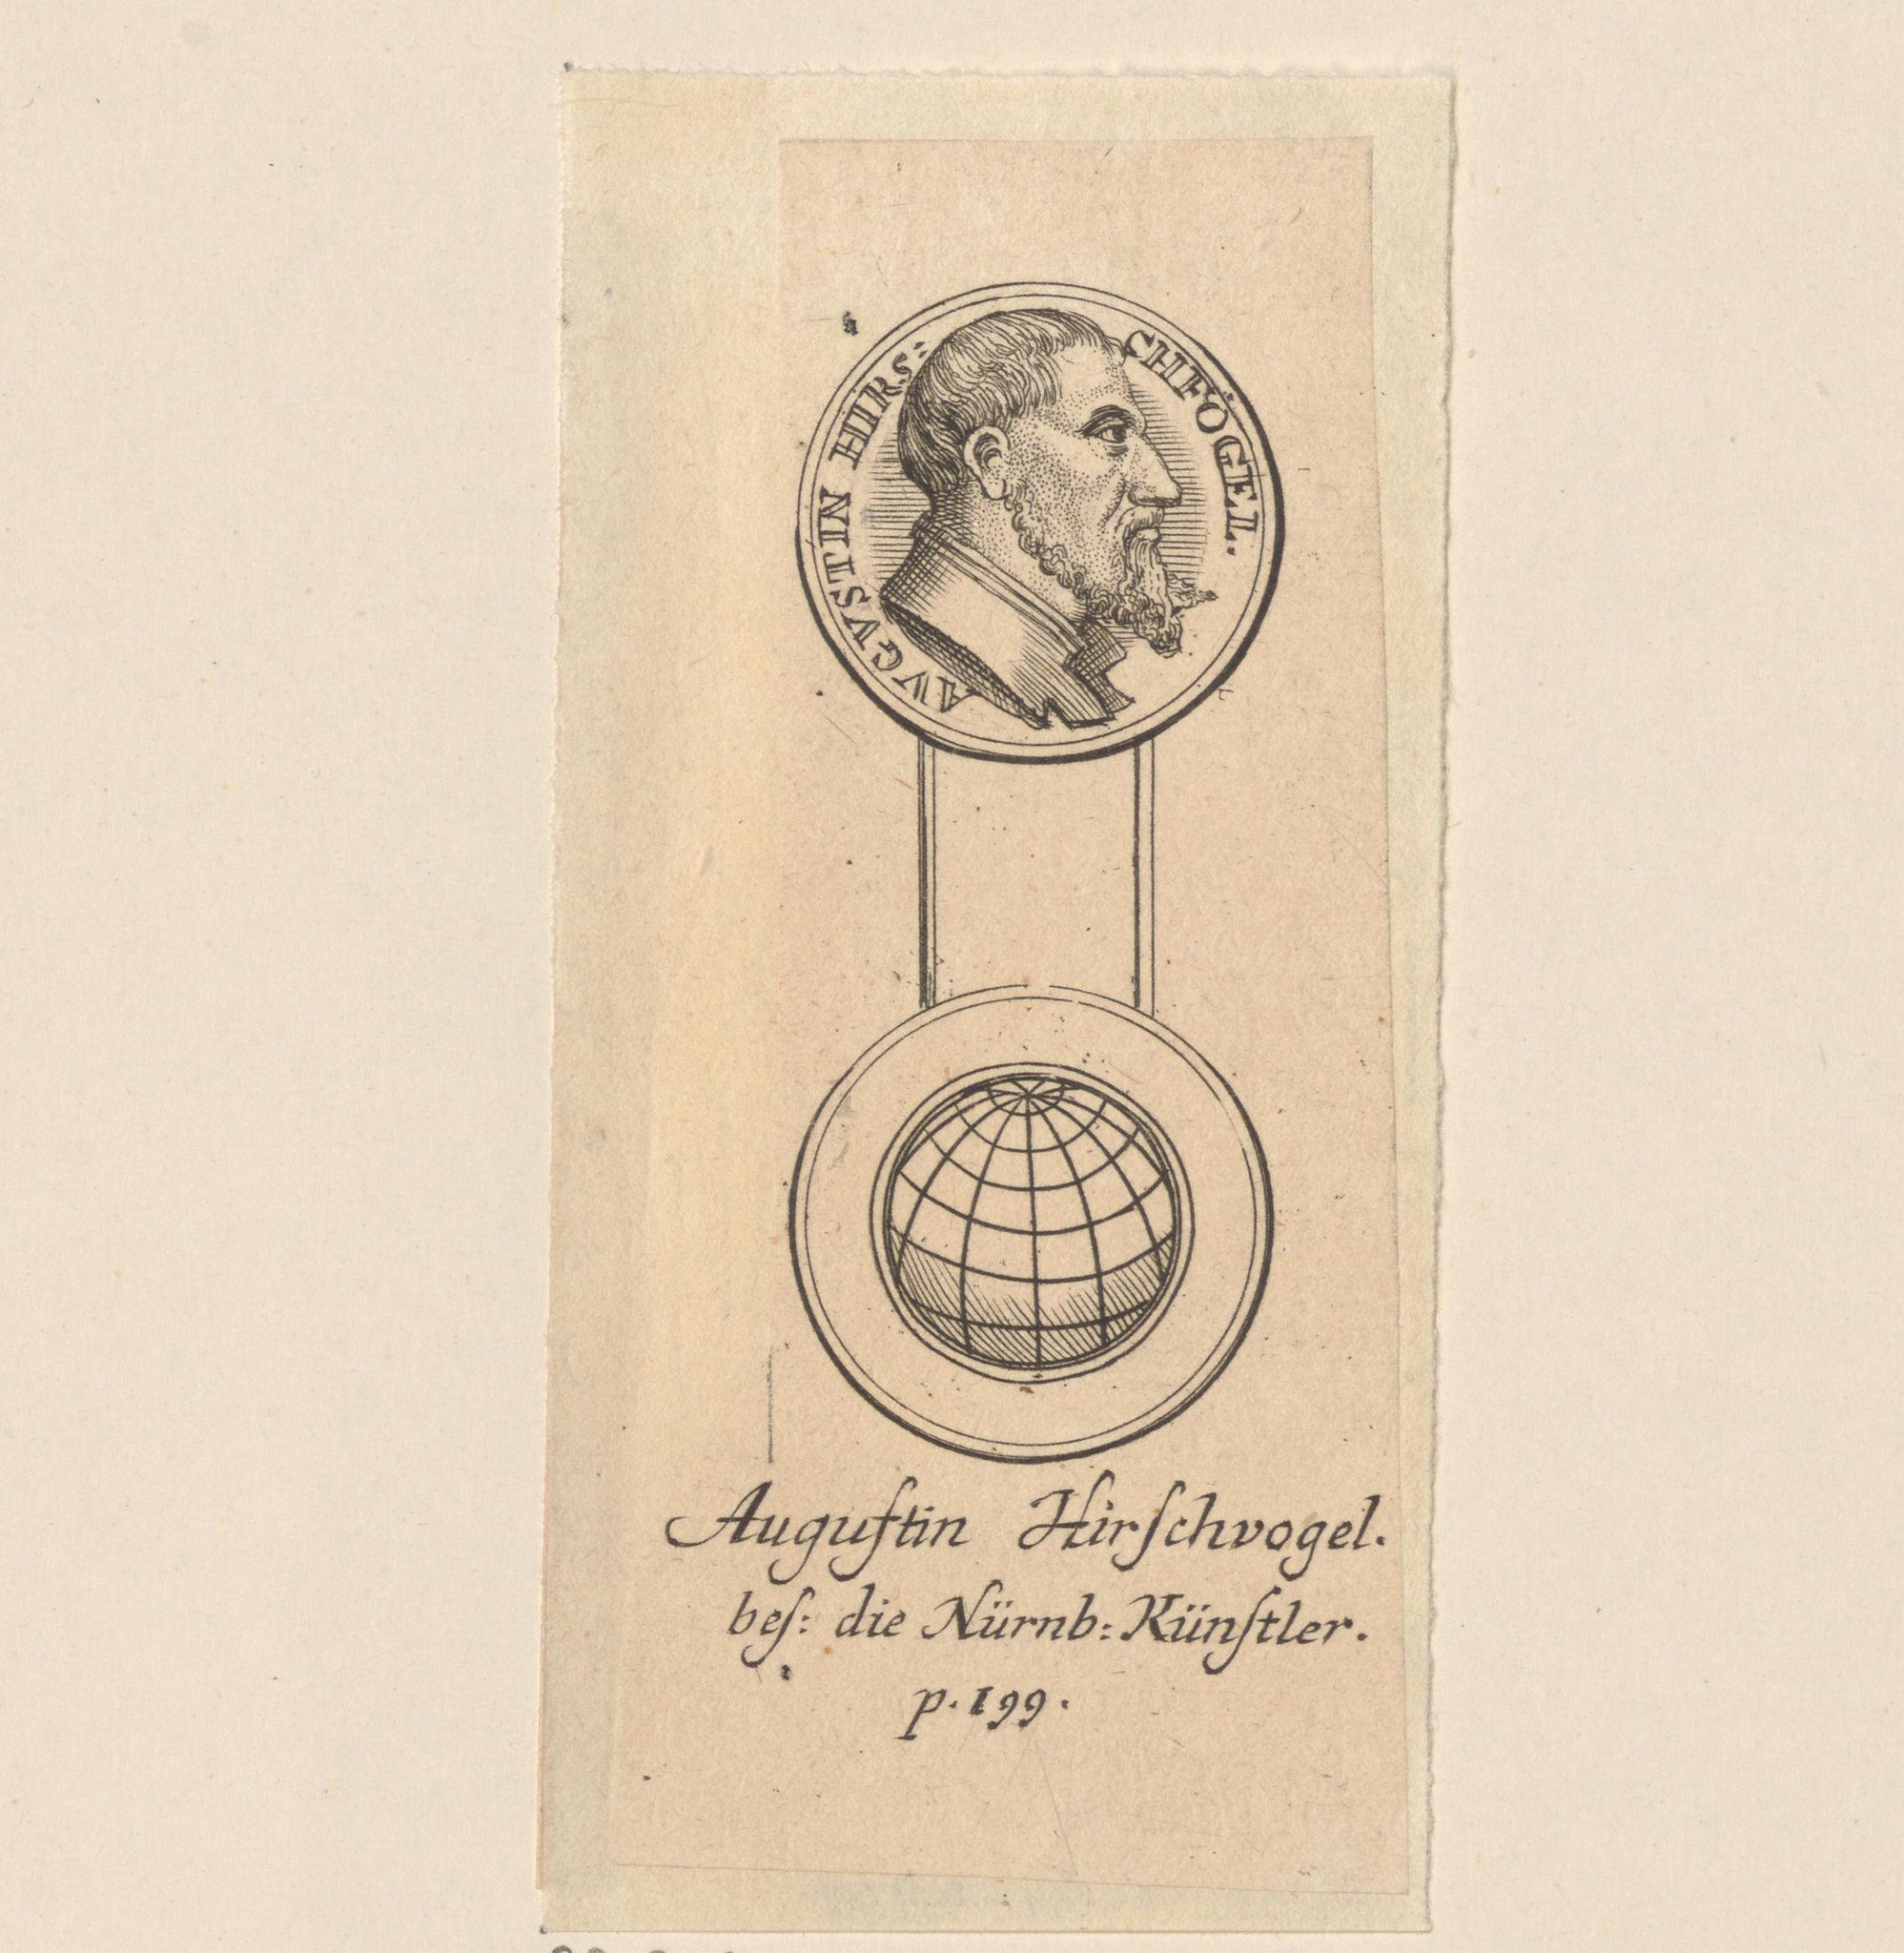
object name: book illustration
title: Penning met portret van Augustin Hirschvogel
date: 1730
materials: paper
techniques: engraving, etching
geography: nuremberg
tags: vienna, print maker, augustin hirschvogel, historical persons, medal (considered as a piece of sculpture, regardless of its specific function), portrait, self-portrait of artist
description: Prent uit: Doppelmayr, Johann Gabriel. Historische Nachricht Von den Nürnbergischen Mathematicis und Künstlern (...). Neurenberg: Petrus Conradus Monath, 1730.